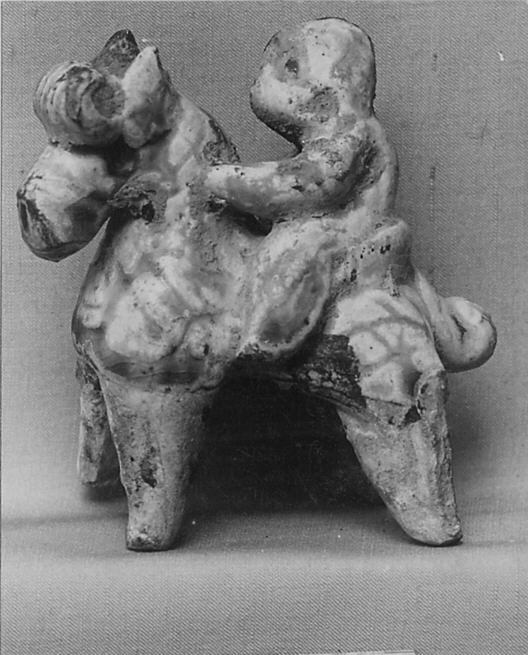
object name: figure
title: Horse and rider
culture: chinese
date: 601-900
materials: earthenware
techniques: glazing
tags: men,horses